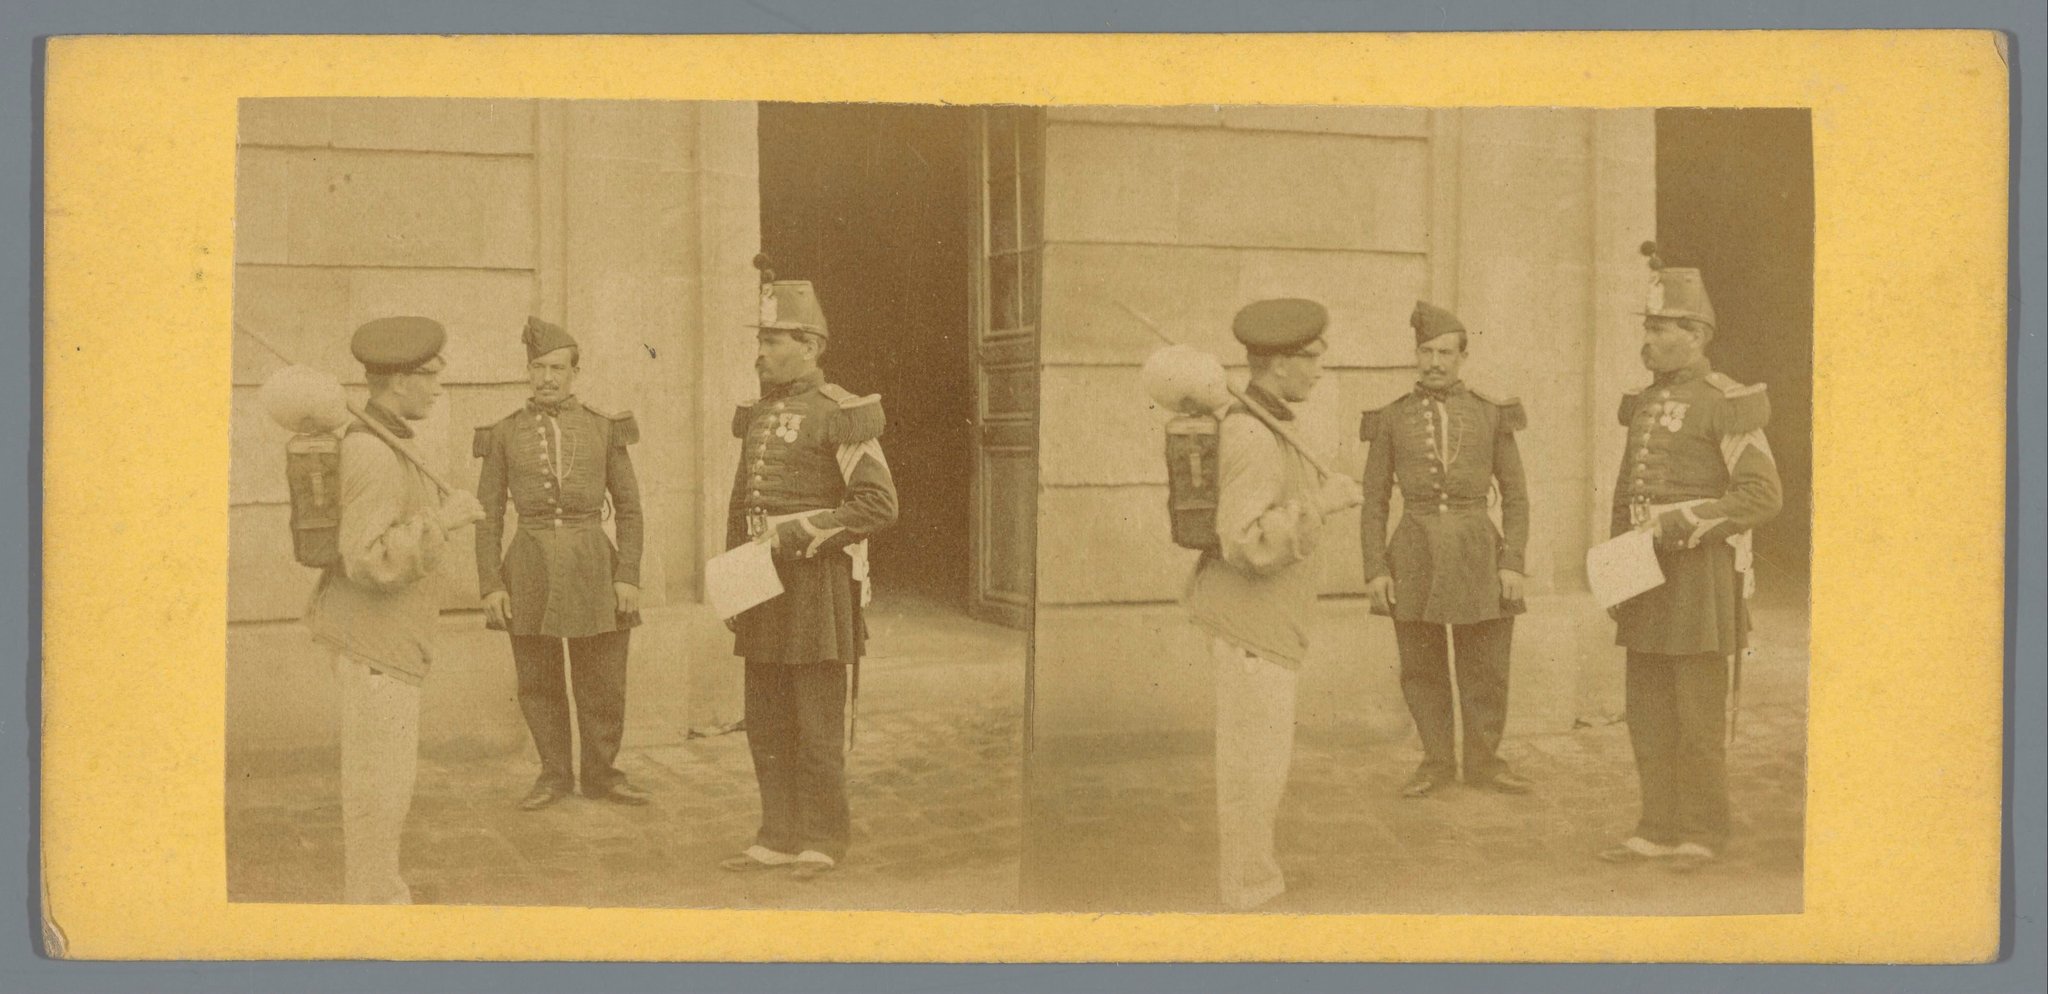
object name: stereograph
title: Twee soldaten en een man met een rugzak voor een kazerne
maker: Anonymous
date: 1850-1880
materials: cardboard, photographic support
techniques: albumen print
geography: europe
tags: the soldier; the soldier's life, europe